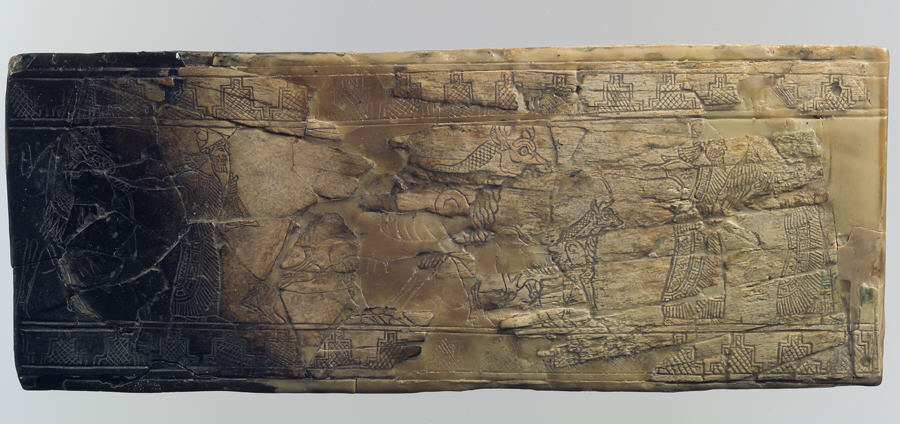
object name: relief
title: Plaque with robed priests leading animals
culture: assyrian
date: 900-701 BCE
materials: ivory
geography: mesopotamia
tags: animals,men